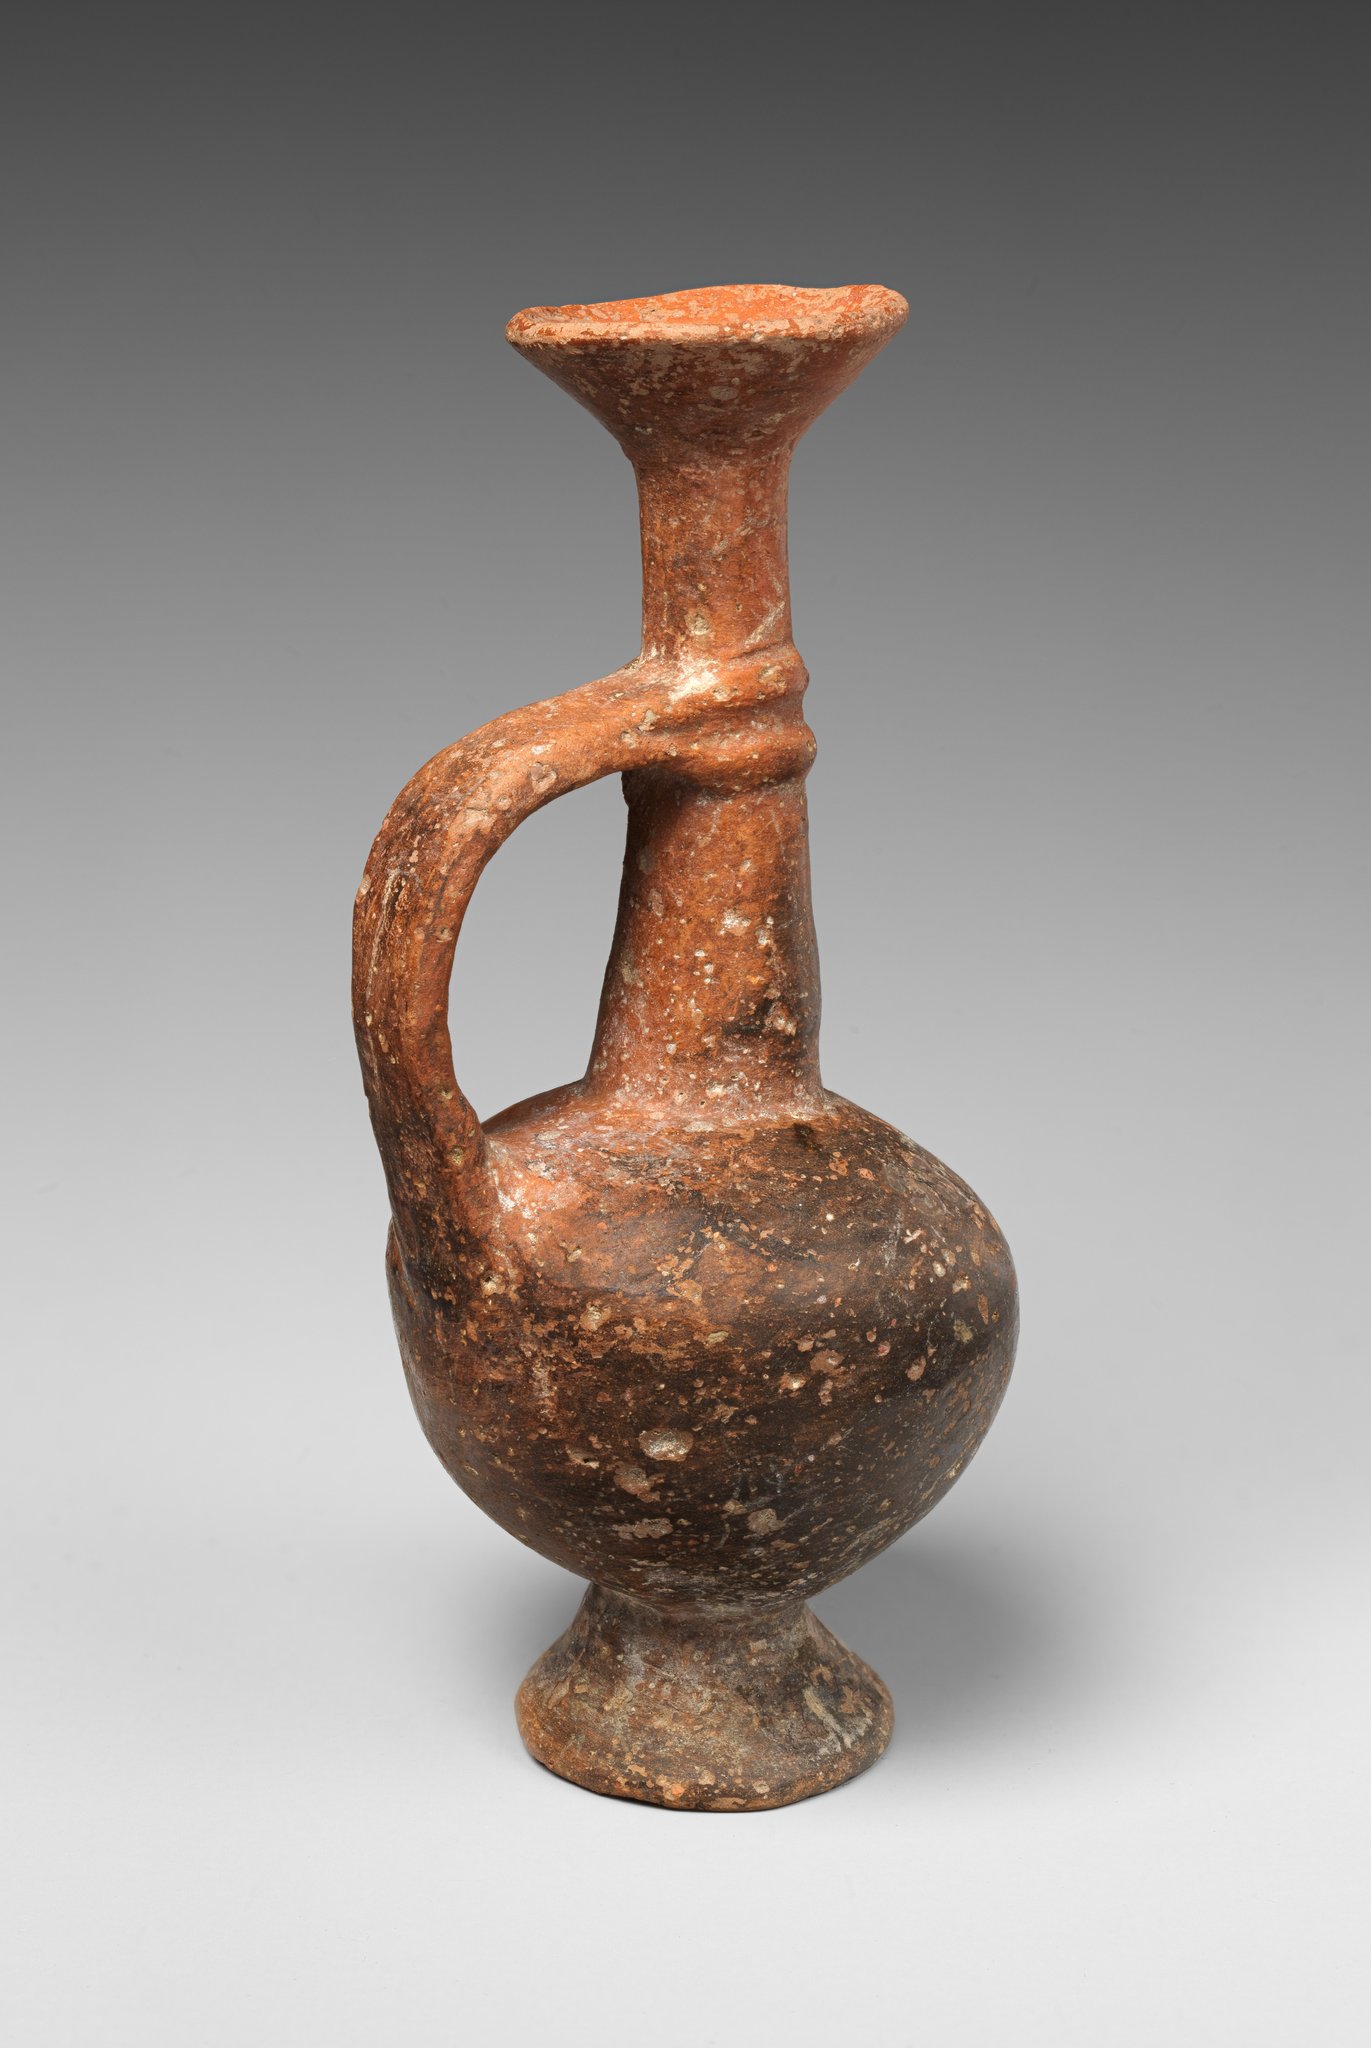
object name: juglet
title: Terracotta juglet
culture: cypriot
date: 1600-1450 BCE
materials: terracotta